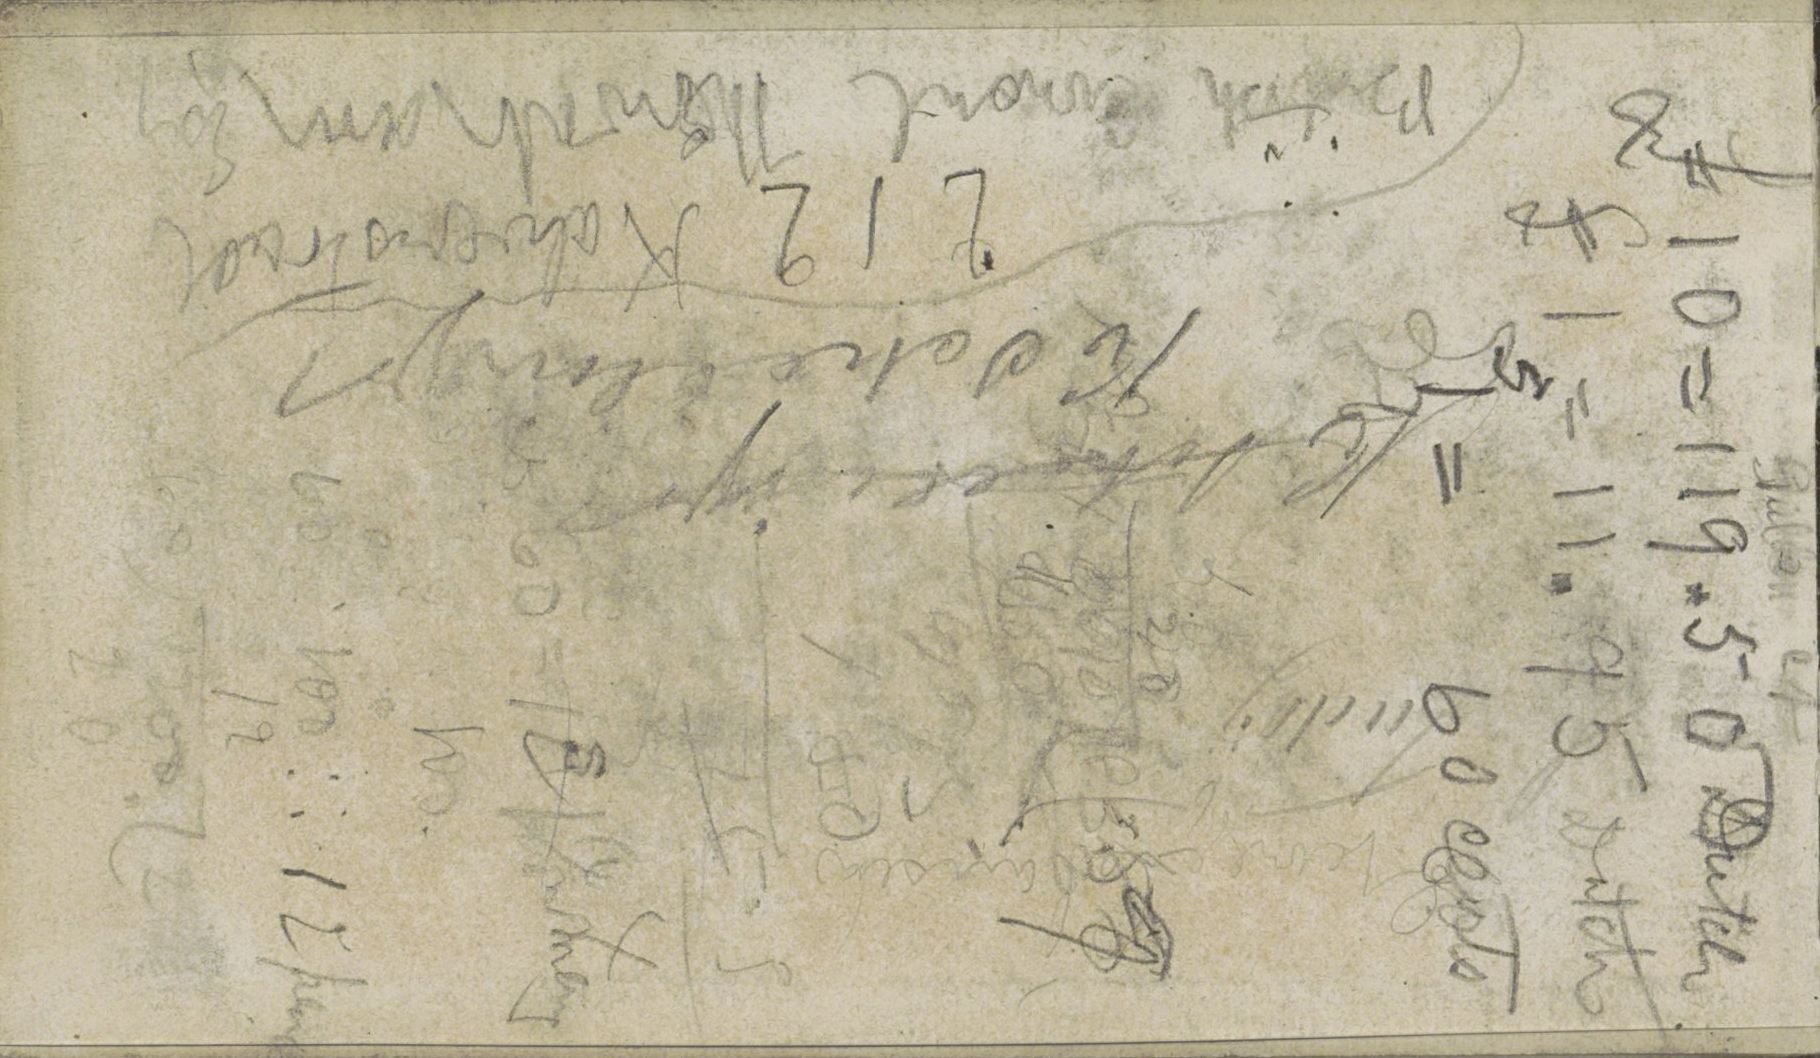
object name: sketchbook leaf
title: Notities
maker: george clausen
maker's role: draughtsman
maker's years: 1852-1912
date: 1875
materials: paper, pencil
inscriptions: annotation: ‘[...] K. Schellings/ 212 Kalverstraat/ British [...]ont [...]ham’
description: Blad 46 verso uit een schetsboek met 46 bladen.